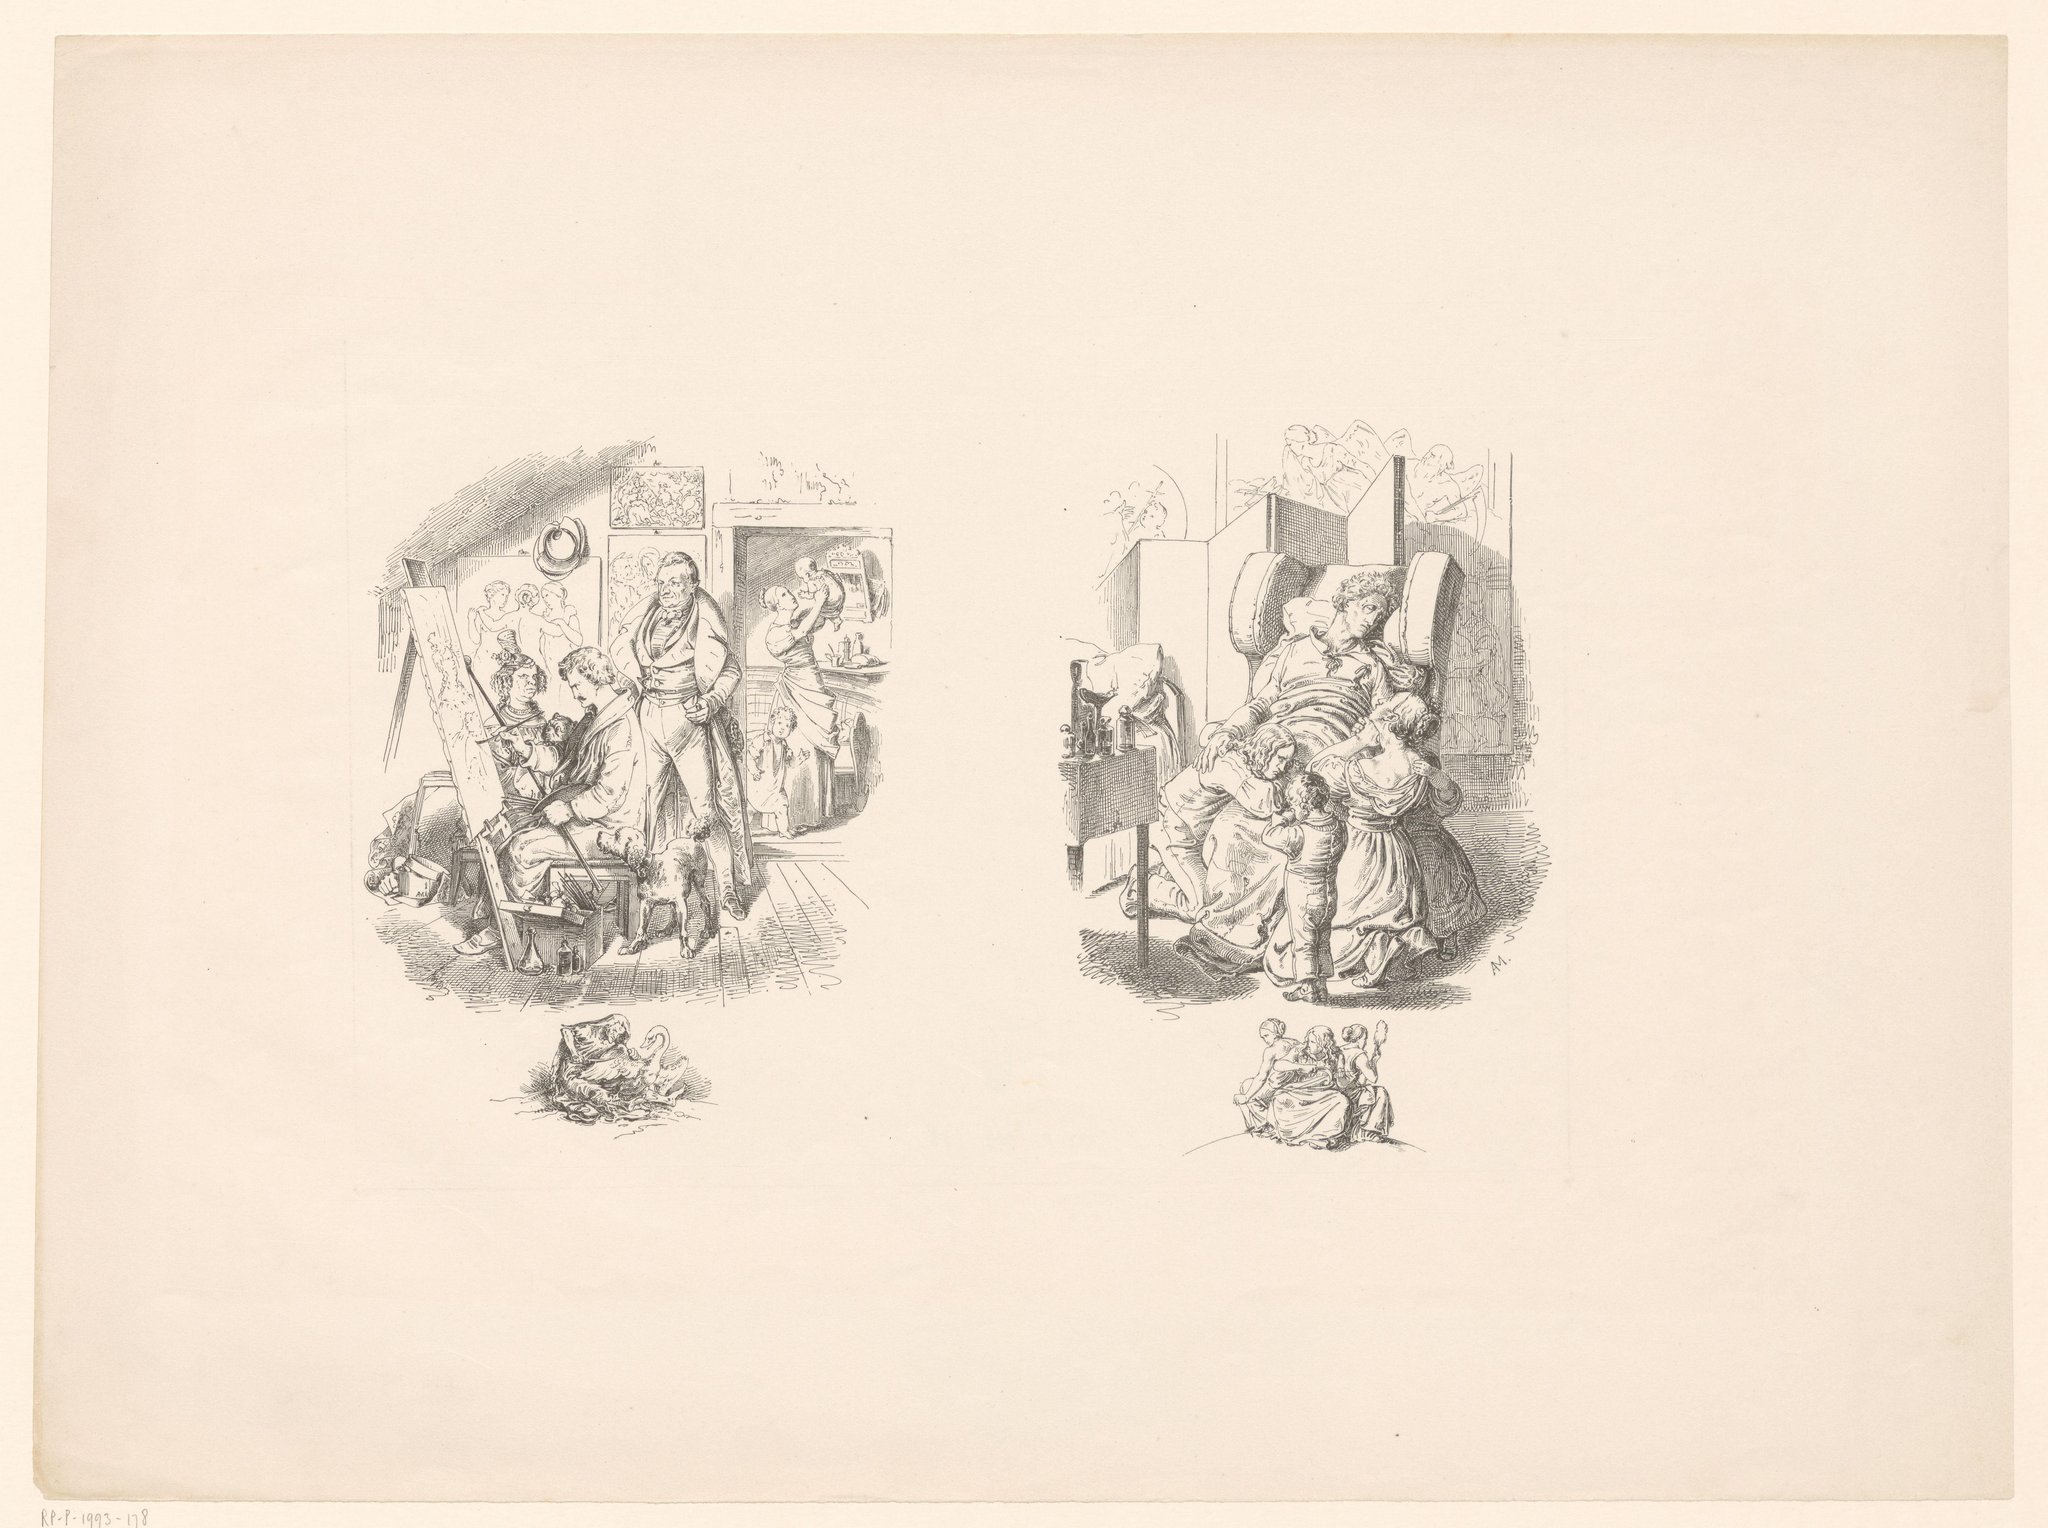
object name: print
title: Künstlers Erdenwallen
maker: adolph menzel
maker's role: draughtsman, painter, print maker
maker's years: 1815-1905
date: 1834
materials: paper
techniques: pen lithography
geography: berlin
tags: the artist and his family, relatives, etc., deathbed, artist on his deathbed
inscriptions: collector's mark: Lugt 2228, collector's mark: Lugt 2760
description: Twee scènes uit het leven van de kunstenaar als getrouwde man. Links is hij aan het werk in zijn werkplaats en schildert een portret van een dame, een opdracht die duidelijk onder zijn niveau is. Dit wordt benadrukt door het embleem onder de voorstelling, van een zwaan die gekortwiekt wordt. Op de scène rechts zit de kunstenaar ziek in een stoel, waarschijnlijk op het einde van zijn leven, met zijn vrouw en drie kinderen om hem heen.